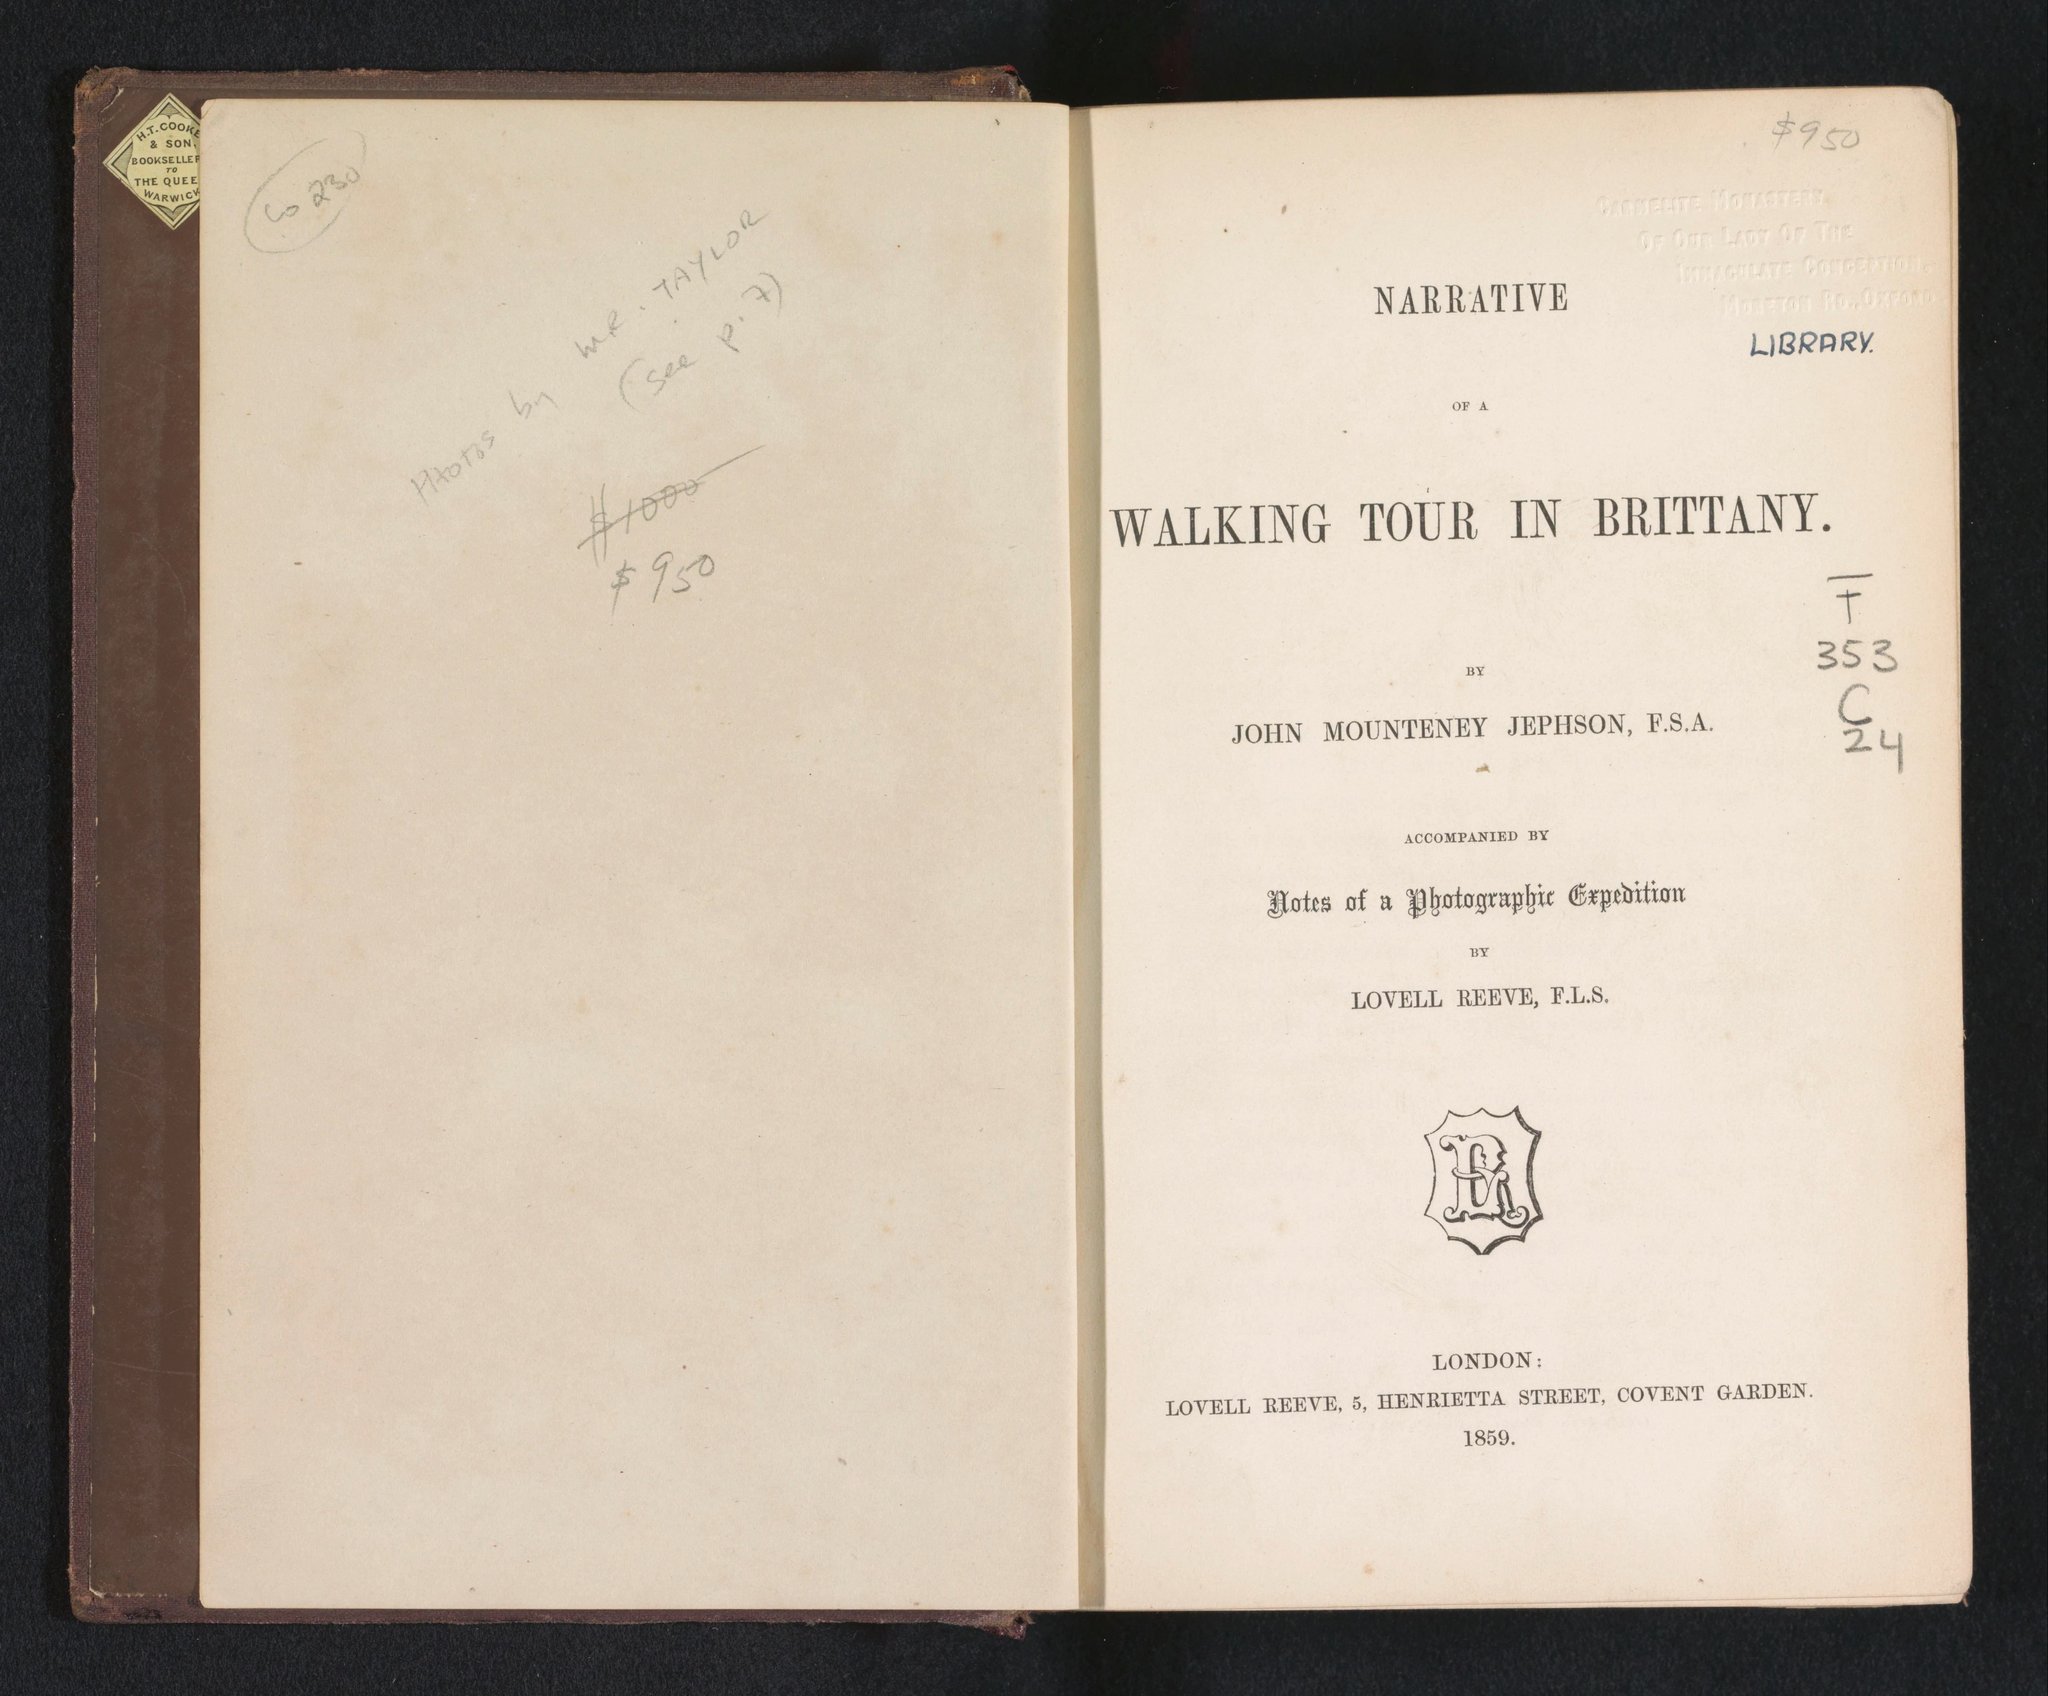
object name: book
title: Narrative of a walking tour in Brittany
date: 1859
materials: cardboard, linen, paper, photographic support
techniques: albumen print, engraving, etching, hand coloring, lithograph, printing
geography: london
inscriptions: inscription: ‘Carmelite Monastery Of Our Lady Of The Immaculate Conception Moreton Rd. Oxford’, name: ‘H.T. Cooke & son. Booksellers. to the Queen. Warwick.’